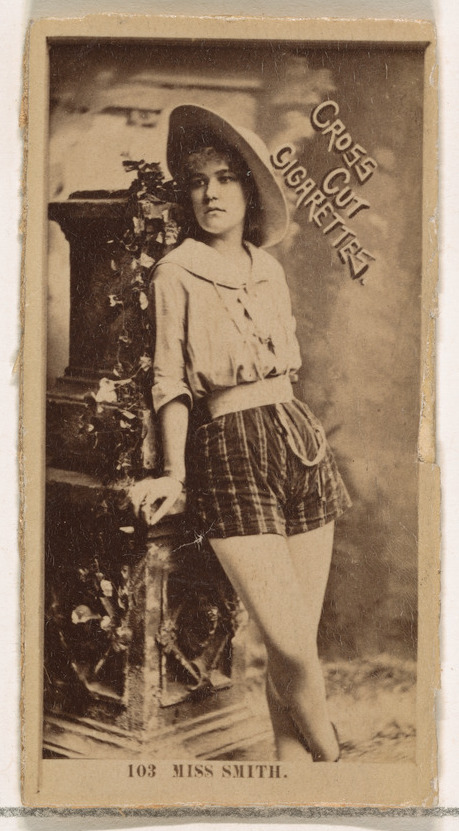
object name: print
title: Card Number 103, Miss Smith, from the Actors and Actresses series (N145-2) issued by Duke Sons & Co. to promote Cross Cut Cigarettes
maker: w. duke, sons & co.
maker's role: publisher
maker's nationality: american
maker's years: 1870-1920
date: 1880-1889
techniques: albumen silver print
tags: portraits,women,actresses